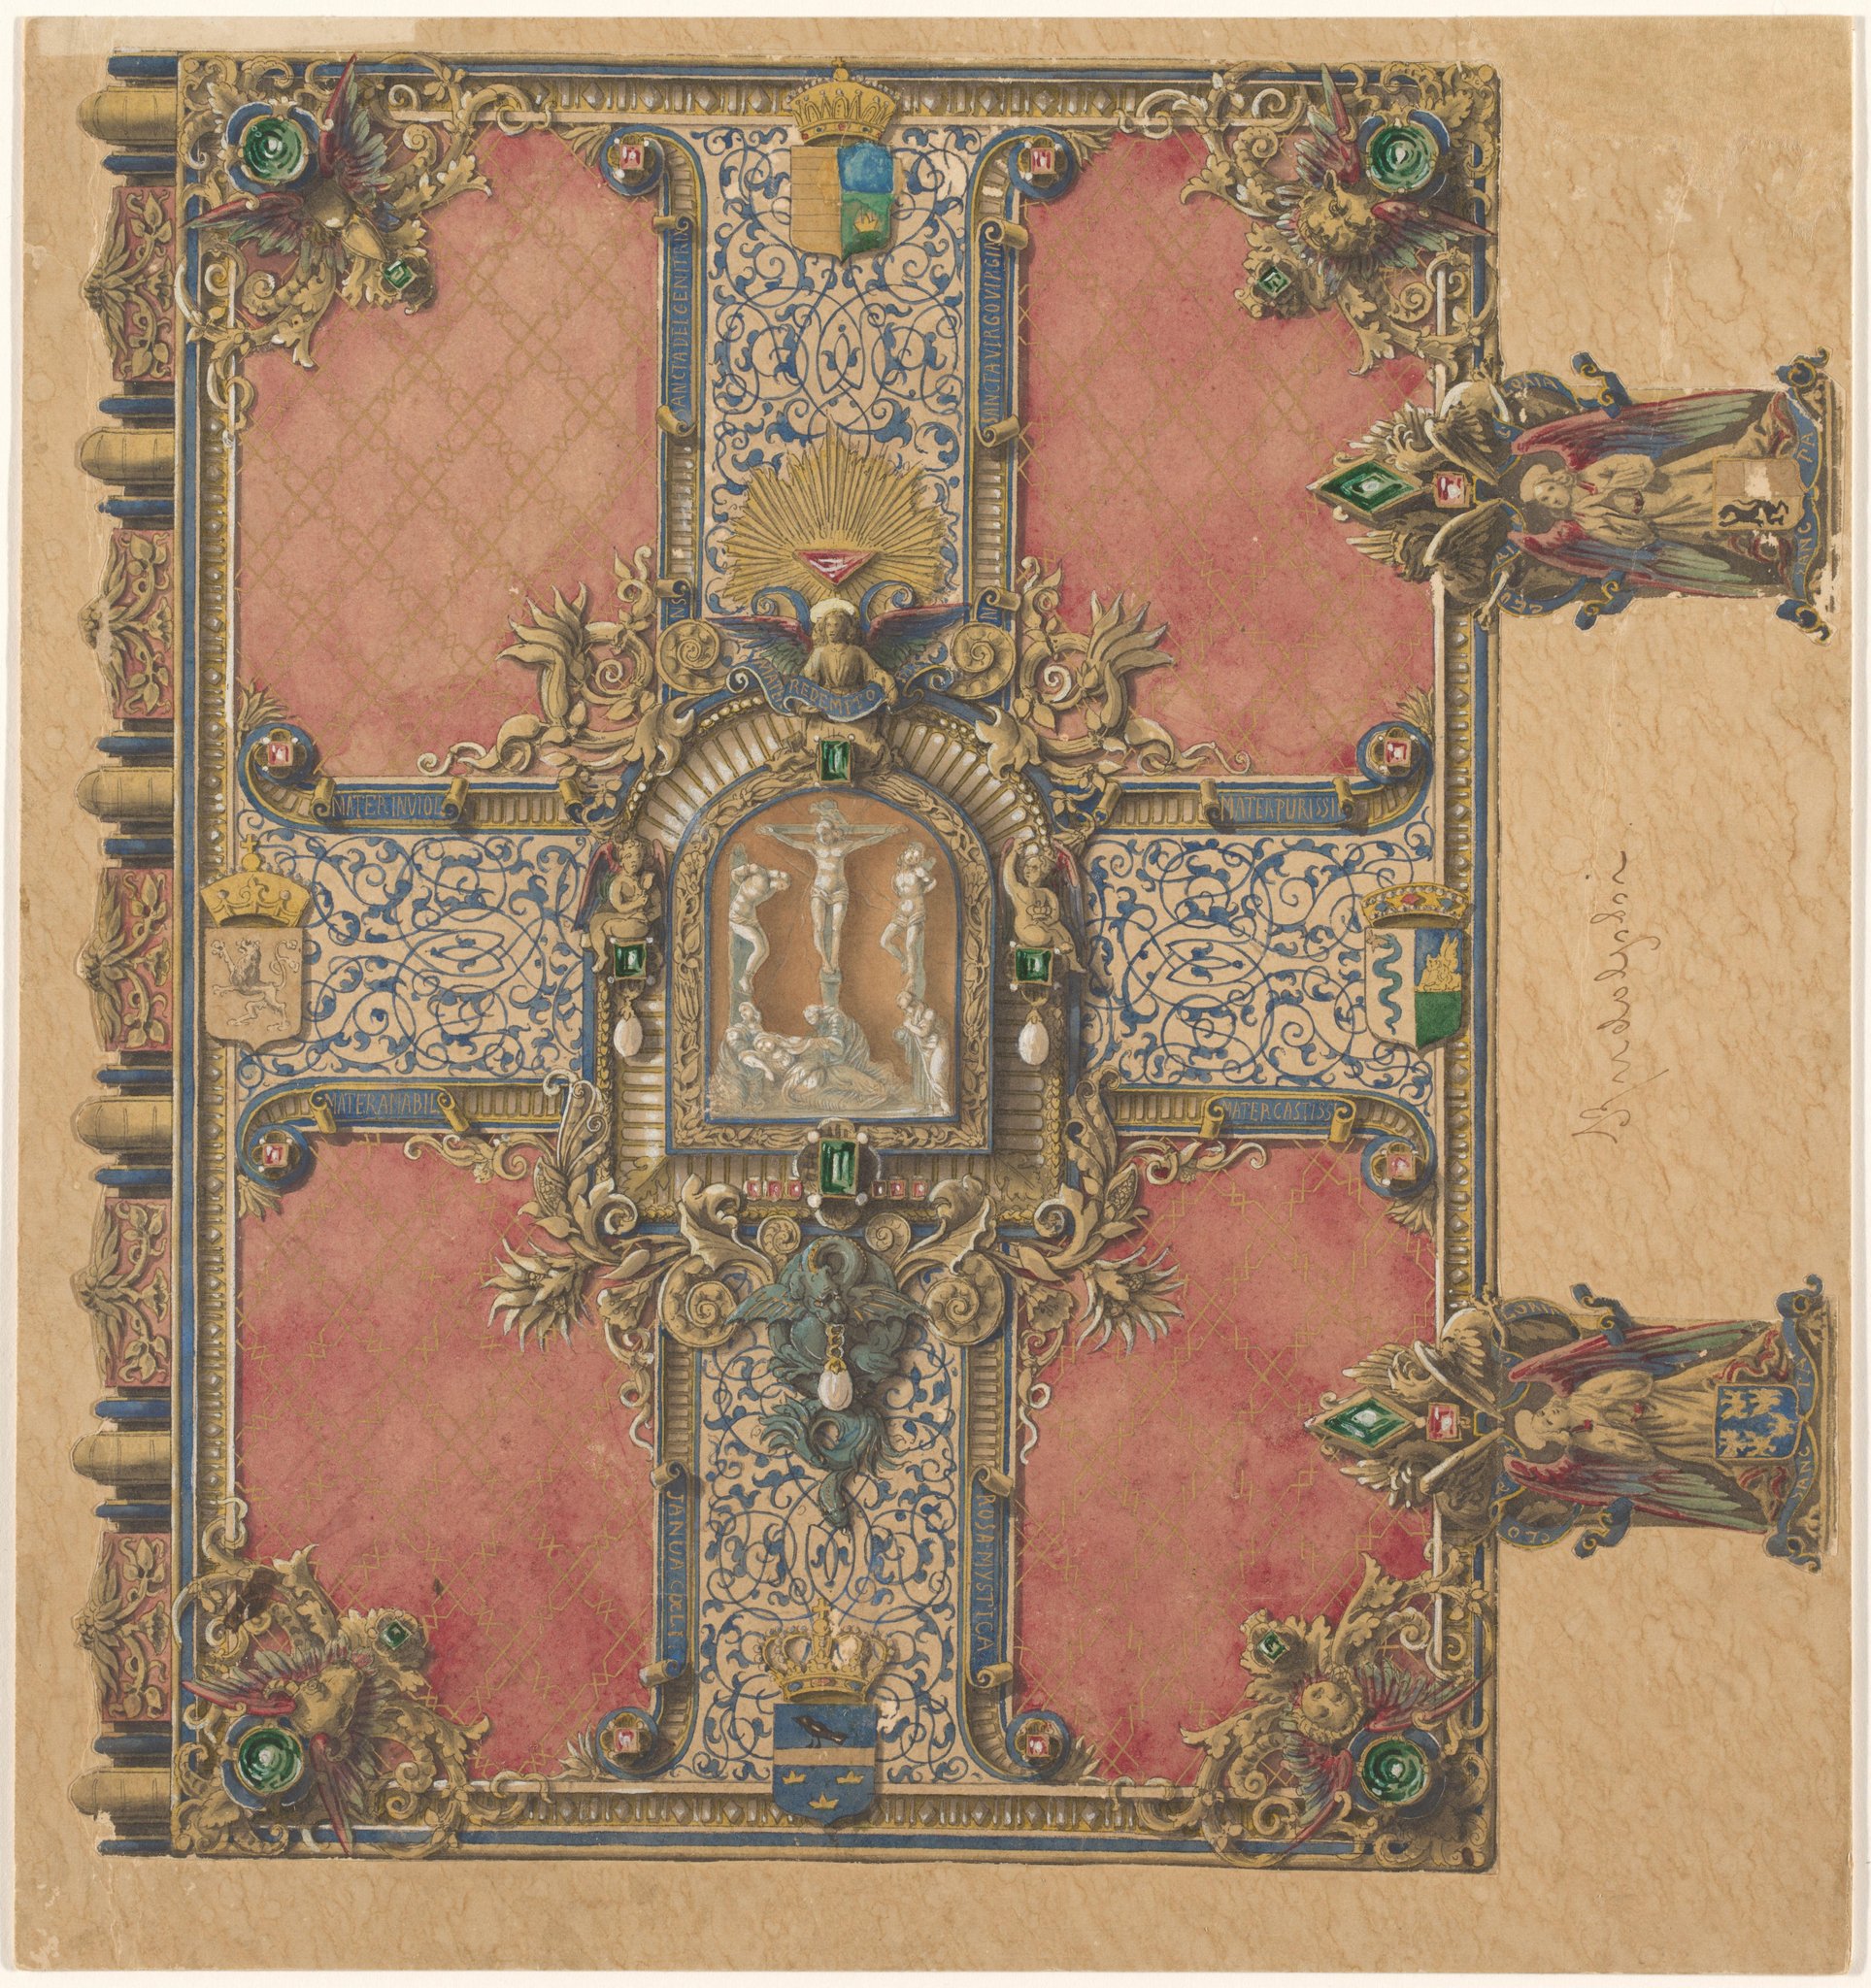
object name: design drawing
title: Ontwerp voor een met edelstenen bezette boekband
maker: frédéric-jules rudolphi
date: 1845-1860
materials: cardboard, gold, ink, paper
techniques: brush, pen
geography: paris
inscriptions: signature: ‘Rudolphi’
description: In het midden een kruisigingsgroep, in het midden van iedere zijde een gekroond wapen (dezelfde als op RP-T-2018-812-3 en op de rug van RP-T-2018-812-1), en banderoles met opschriften in goud: SANCTA DEI GENITRIX / SANCTA VIRGO VIRGIN[UIS] / MATER INVIOL[ATA] / MATER PURISSI[MA] / MATER AMABIL[IS] / MATER CASTISSI[MA] / ROSA MYSTICA / JANUA COELI. In de vier hoeken de symbolen van de evangelisten. De klampen elk met een engel boven een banderol met het opschrift in goud: SANCTA.